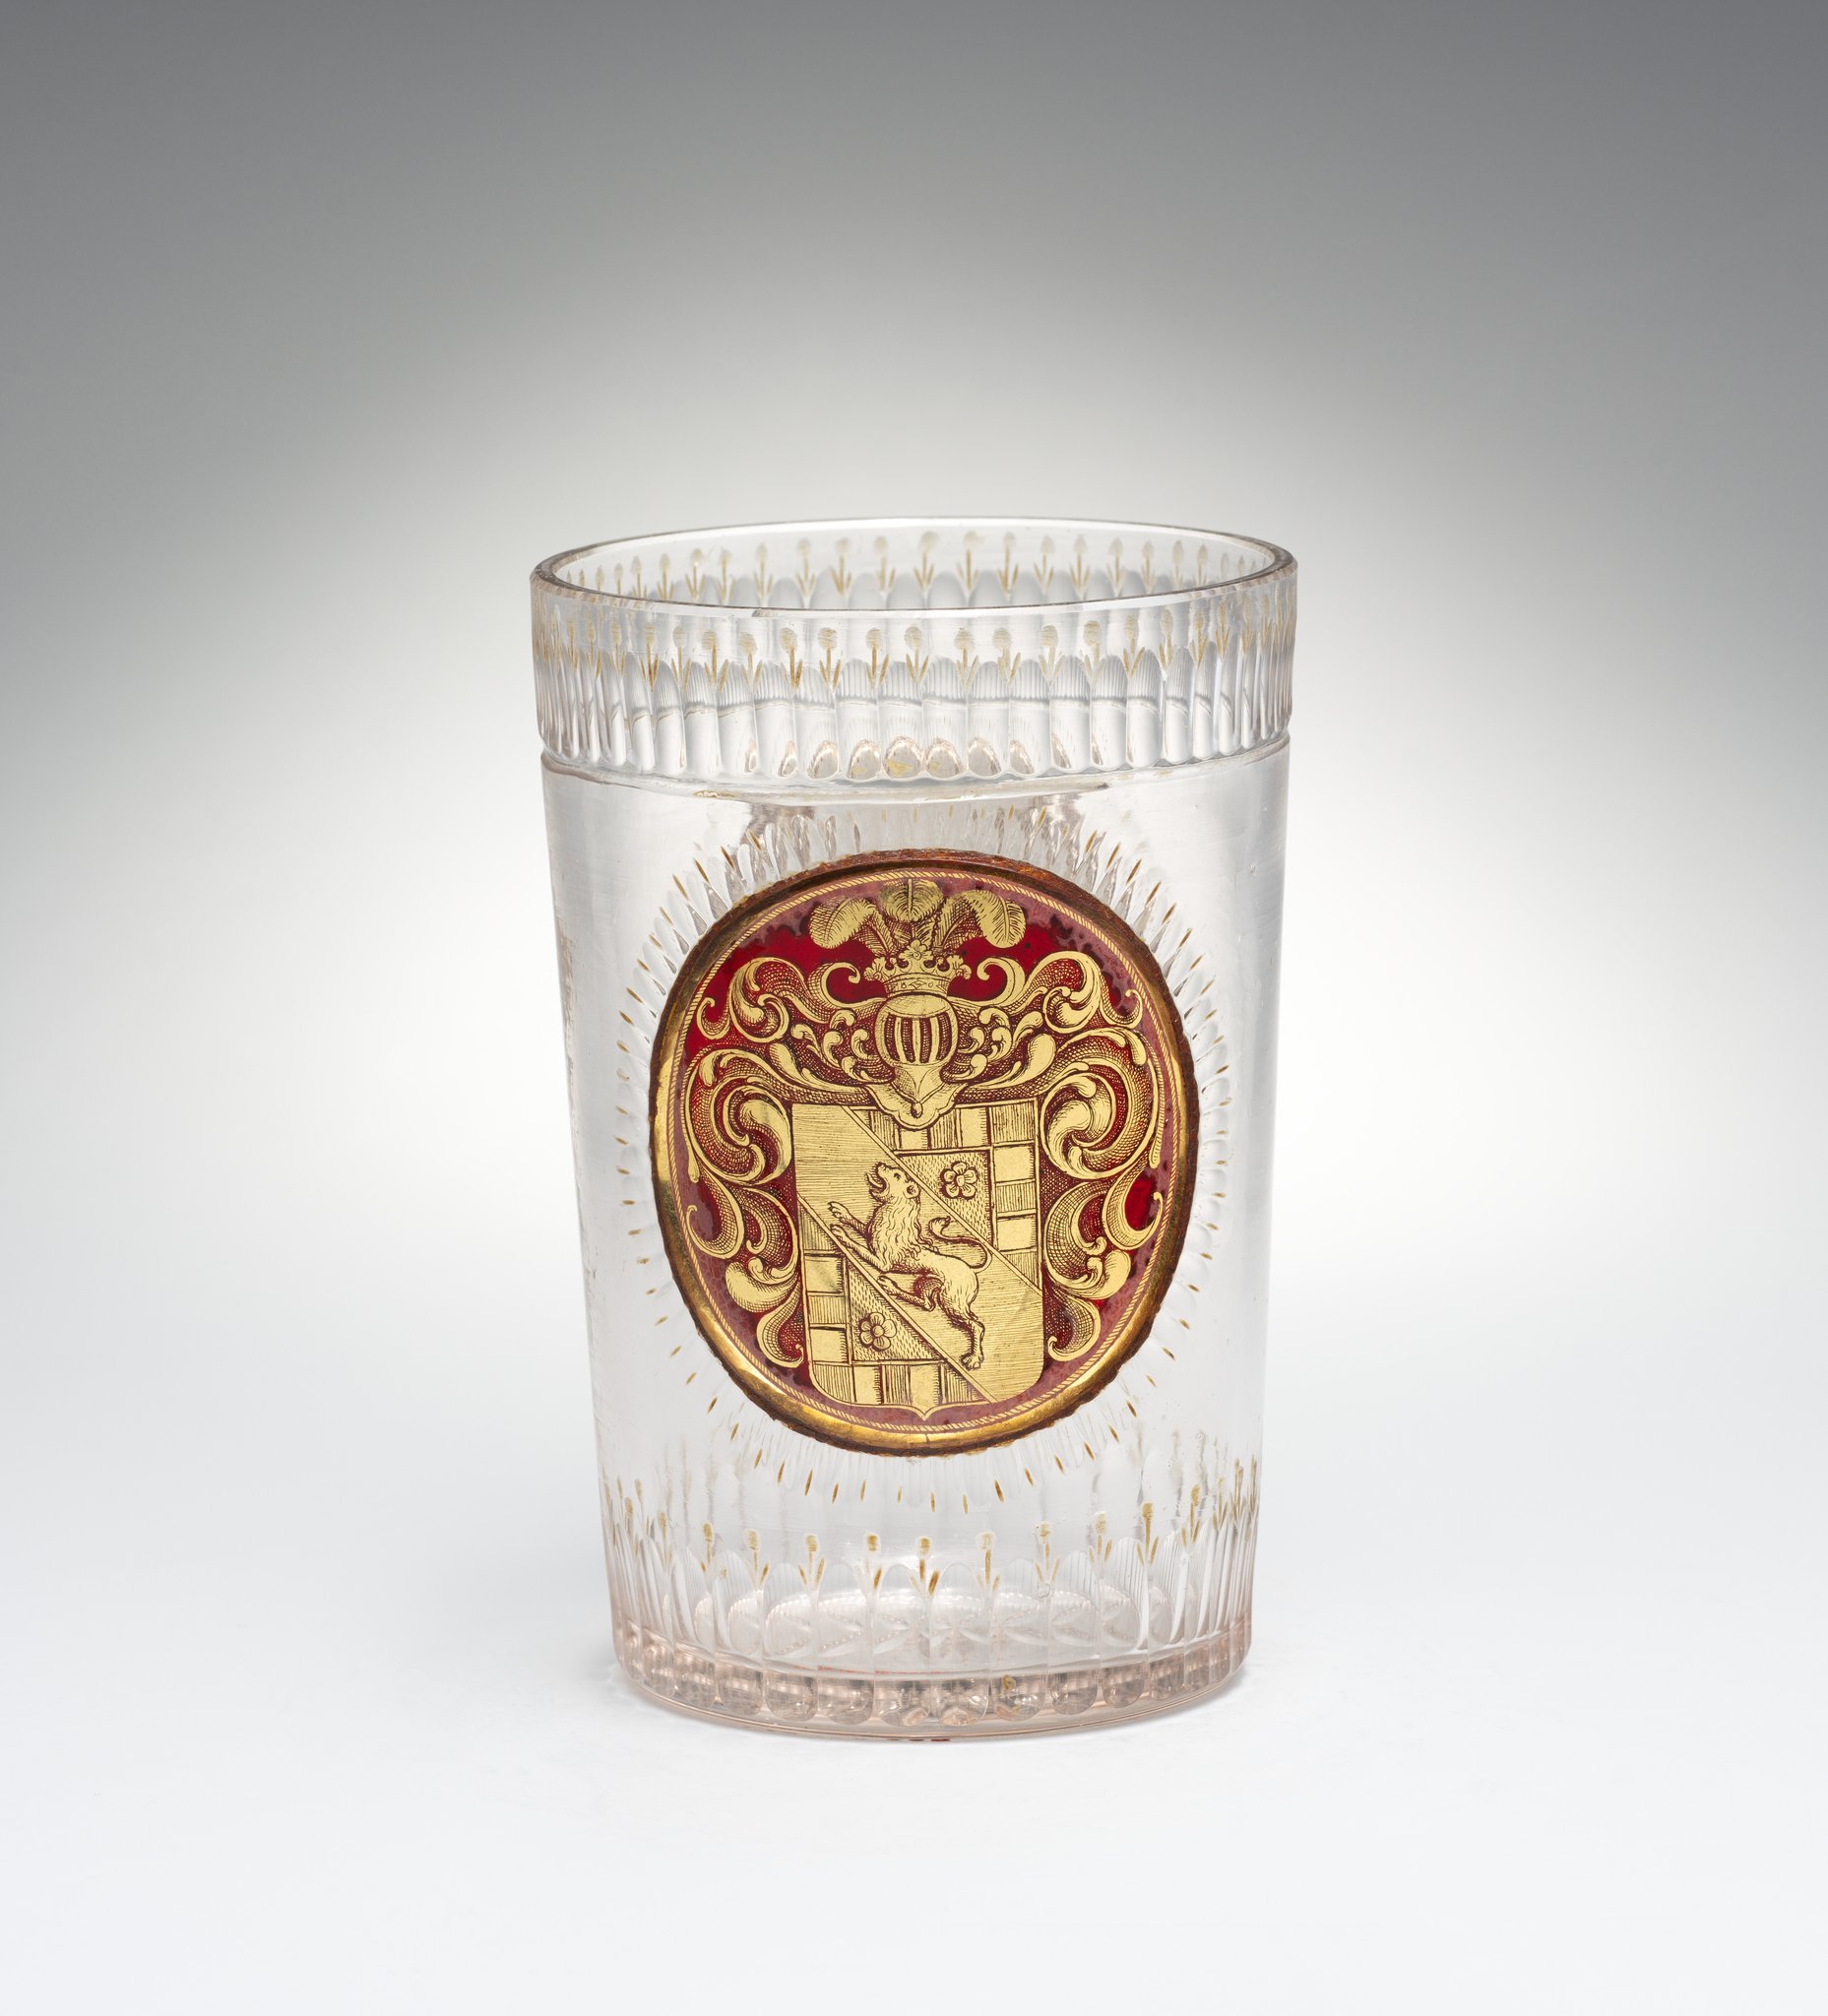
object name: beaker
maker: johann joseph mildner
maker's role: decorator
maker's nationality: austrian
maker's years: 1764-1808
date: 1785-1790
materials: glass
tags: coat of arms